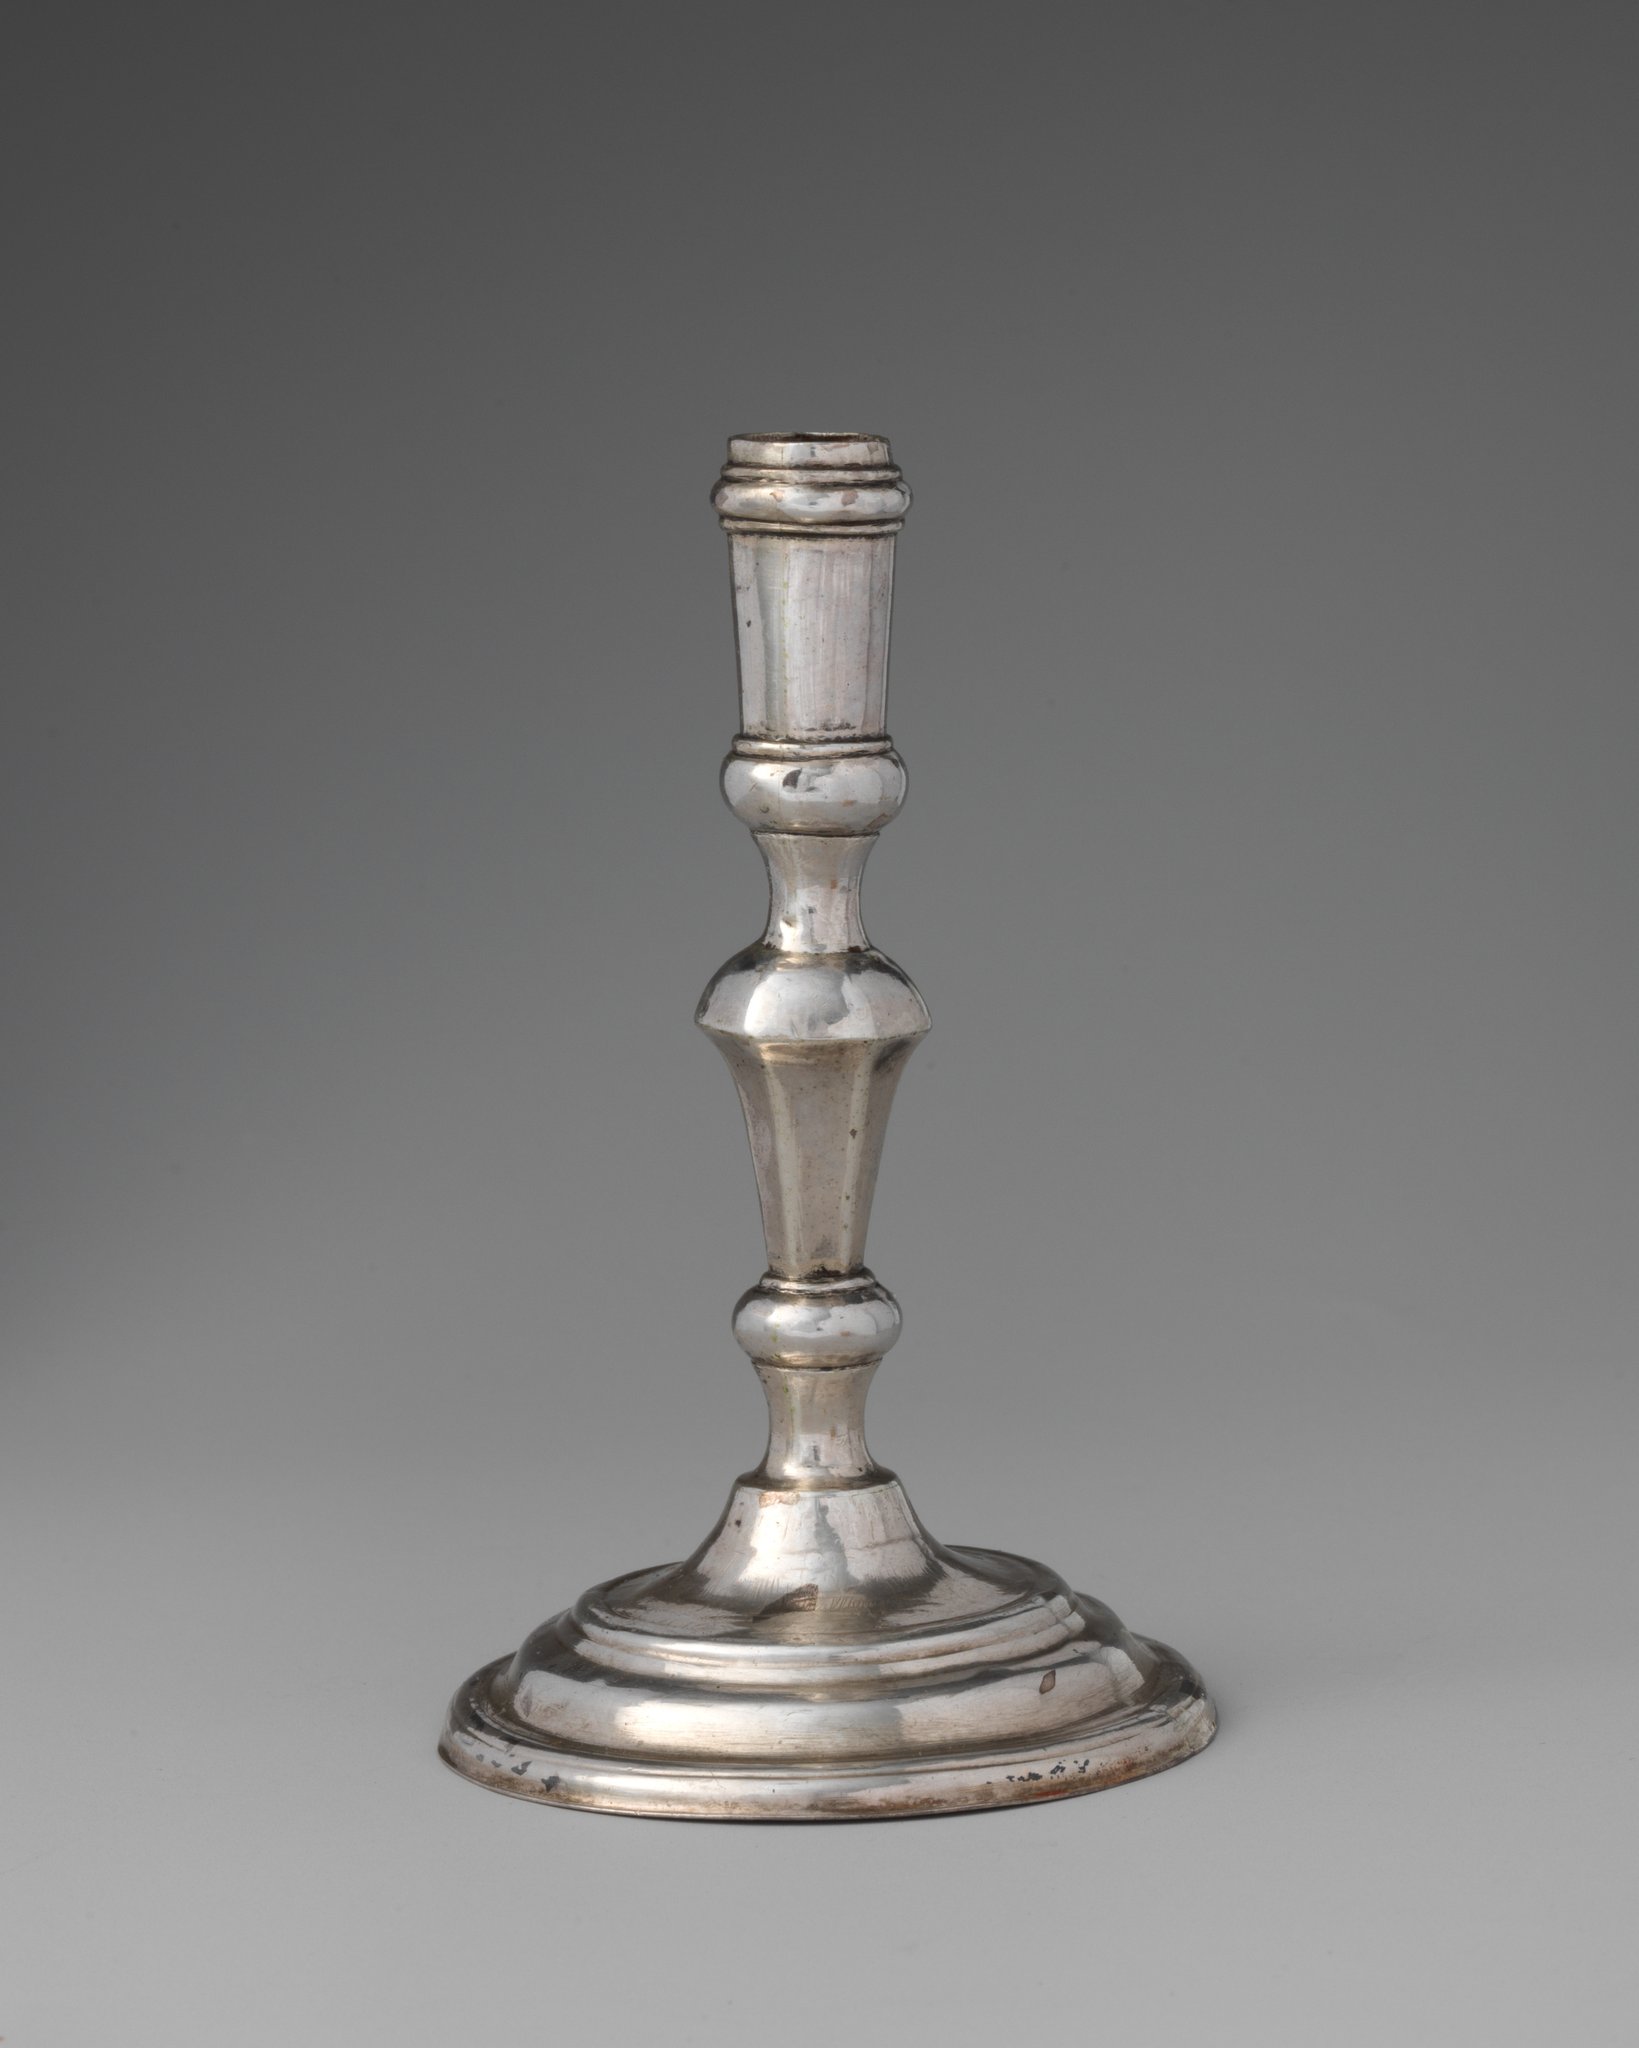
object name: candlestick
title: Miniature candlestick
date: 1701-1800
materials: silver